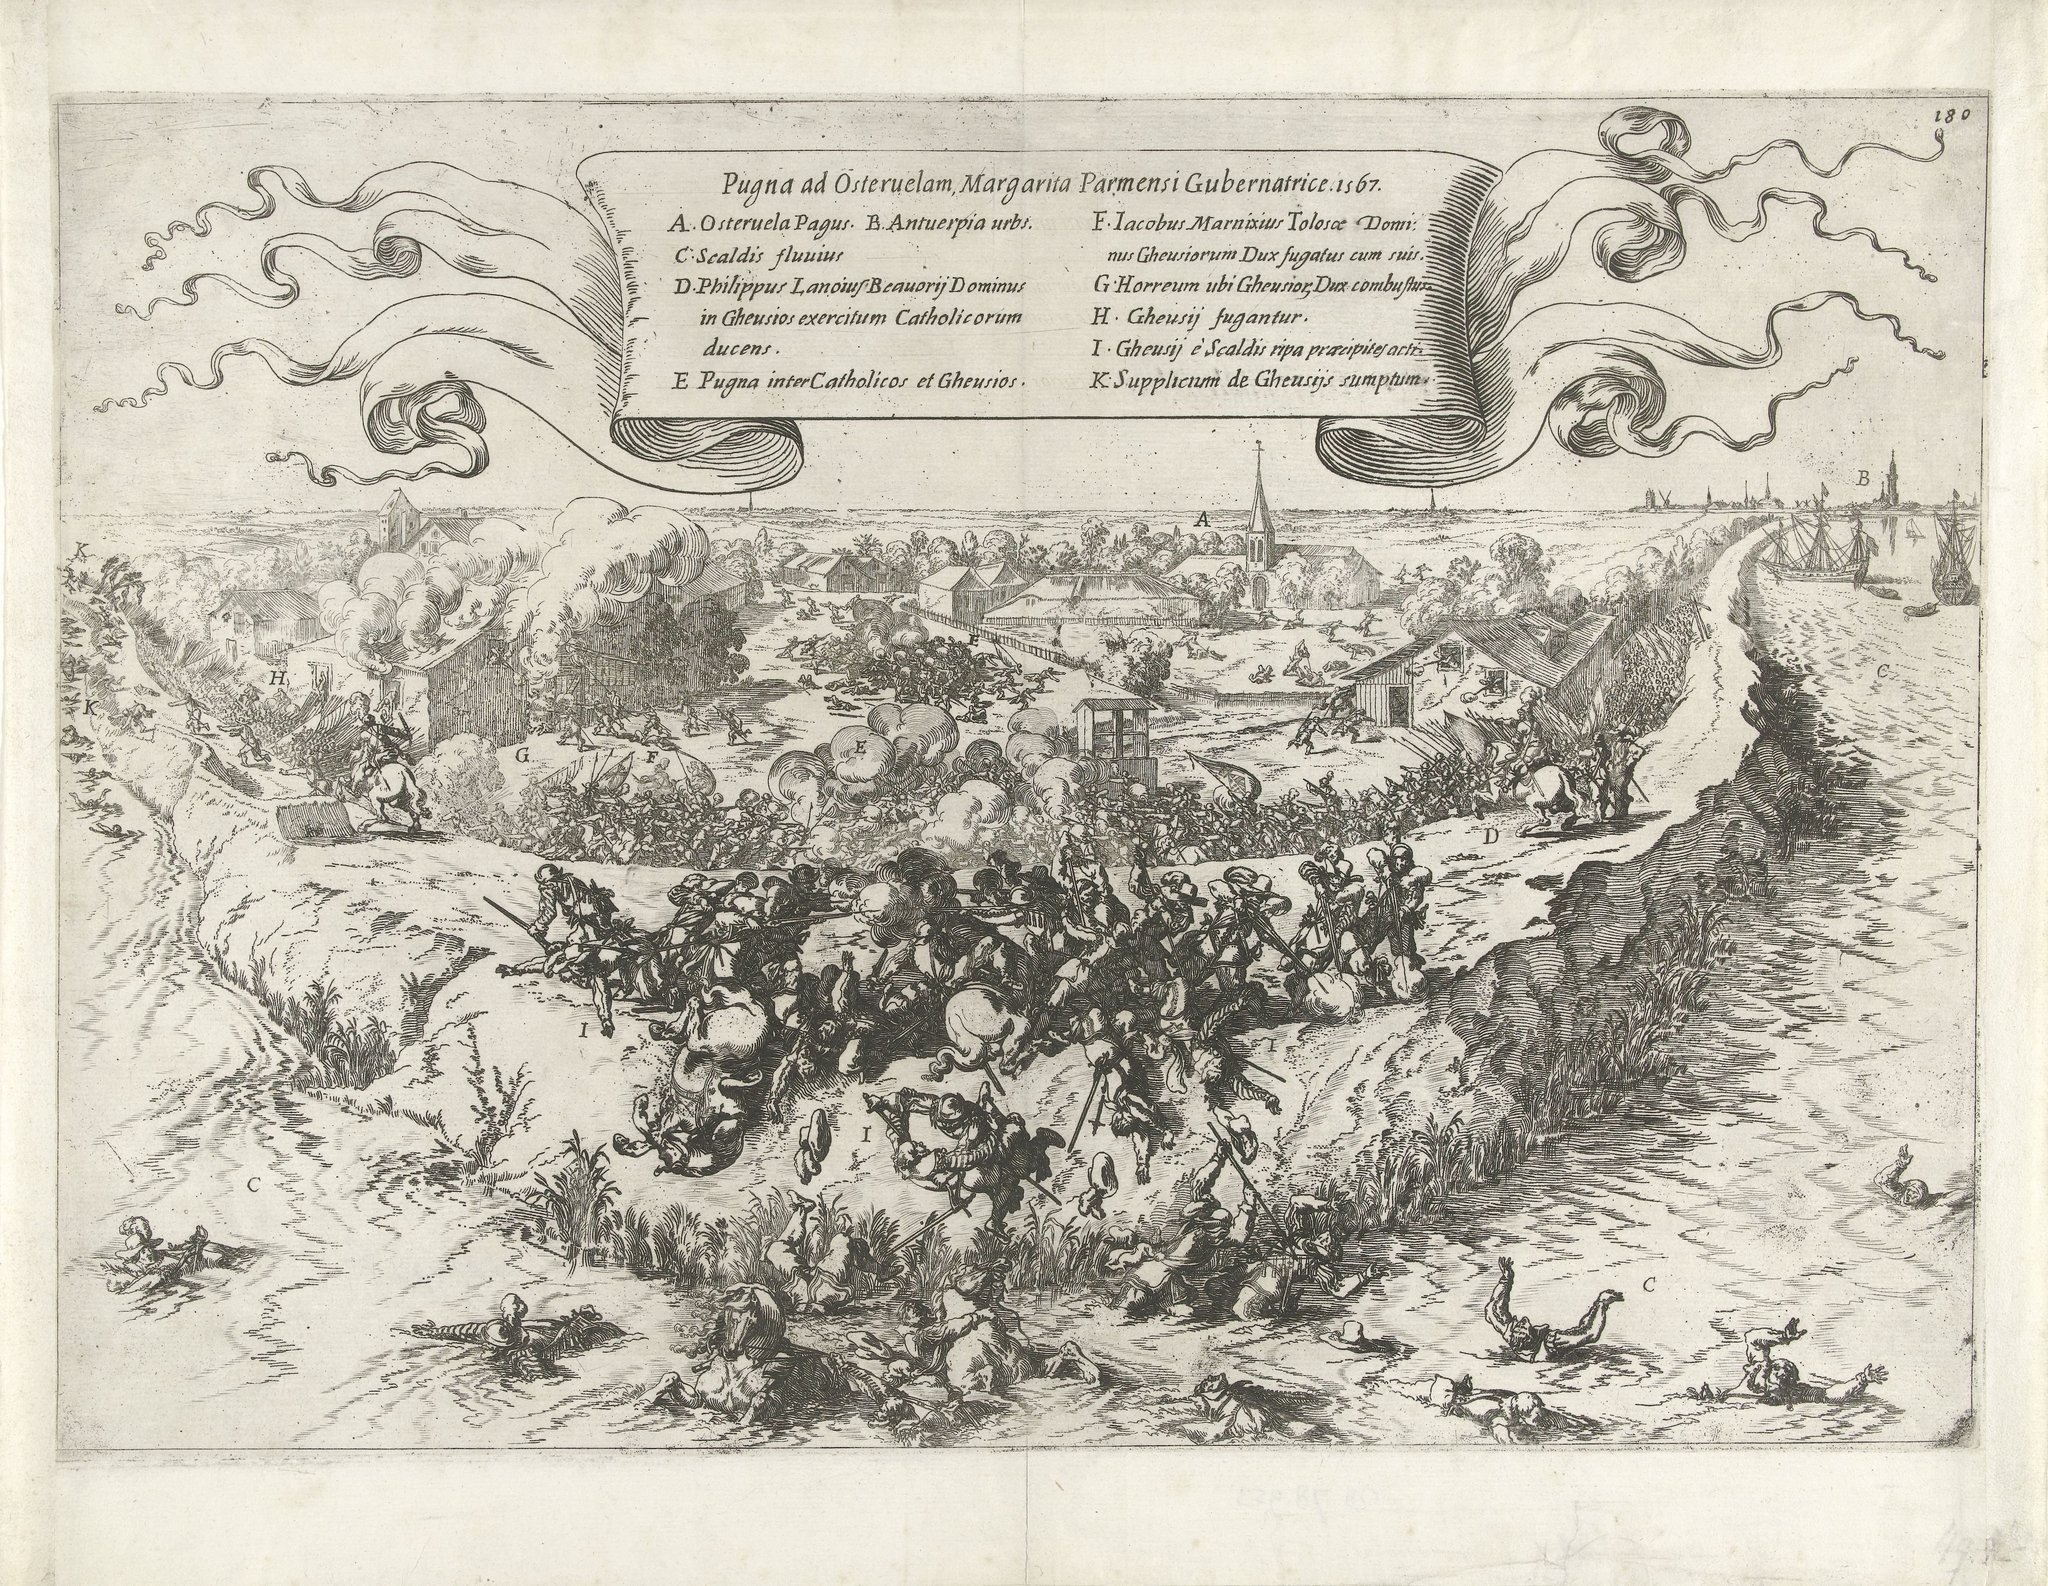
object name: print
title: Slag bij Oosterweel, 1567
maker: johann wilhelm baur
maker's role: draughtsman, painter, print maker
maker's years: 1607-1642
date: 1630-1632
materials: paper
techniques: etching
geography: rome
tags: battle, fighting in general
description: Slag bij Oosterweel, 13 maart 1567. De gevechten voor het dorpje Oosterweel buiten Antwerpen. De calvinisten onder leiding van Jan van Marnix worden verslagen door de troepen van de hertog van Aremberg en Philips van Lanoy. Rechts de Schelde. Bovenaan een banderol de titel en de legenda A-K in het Latijn.